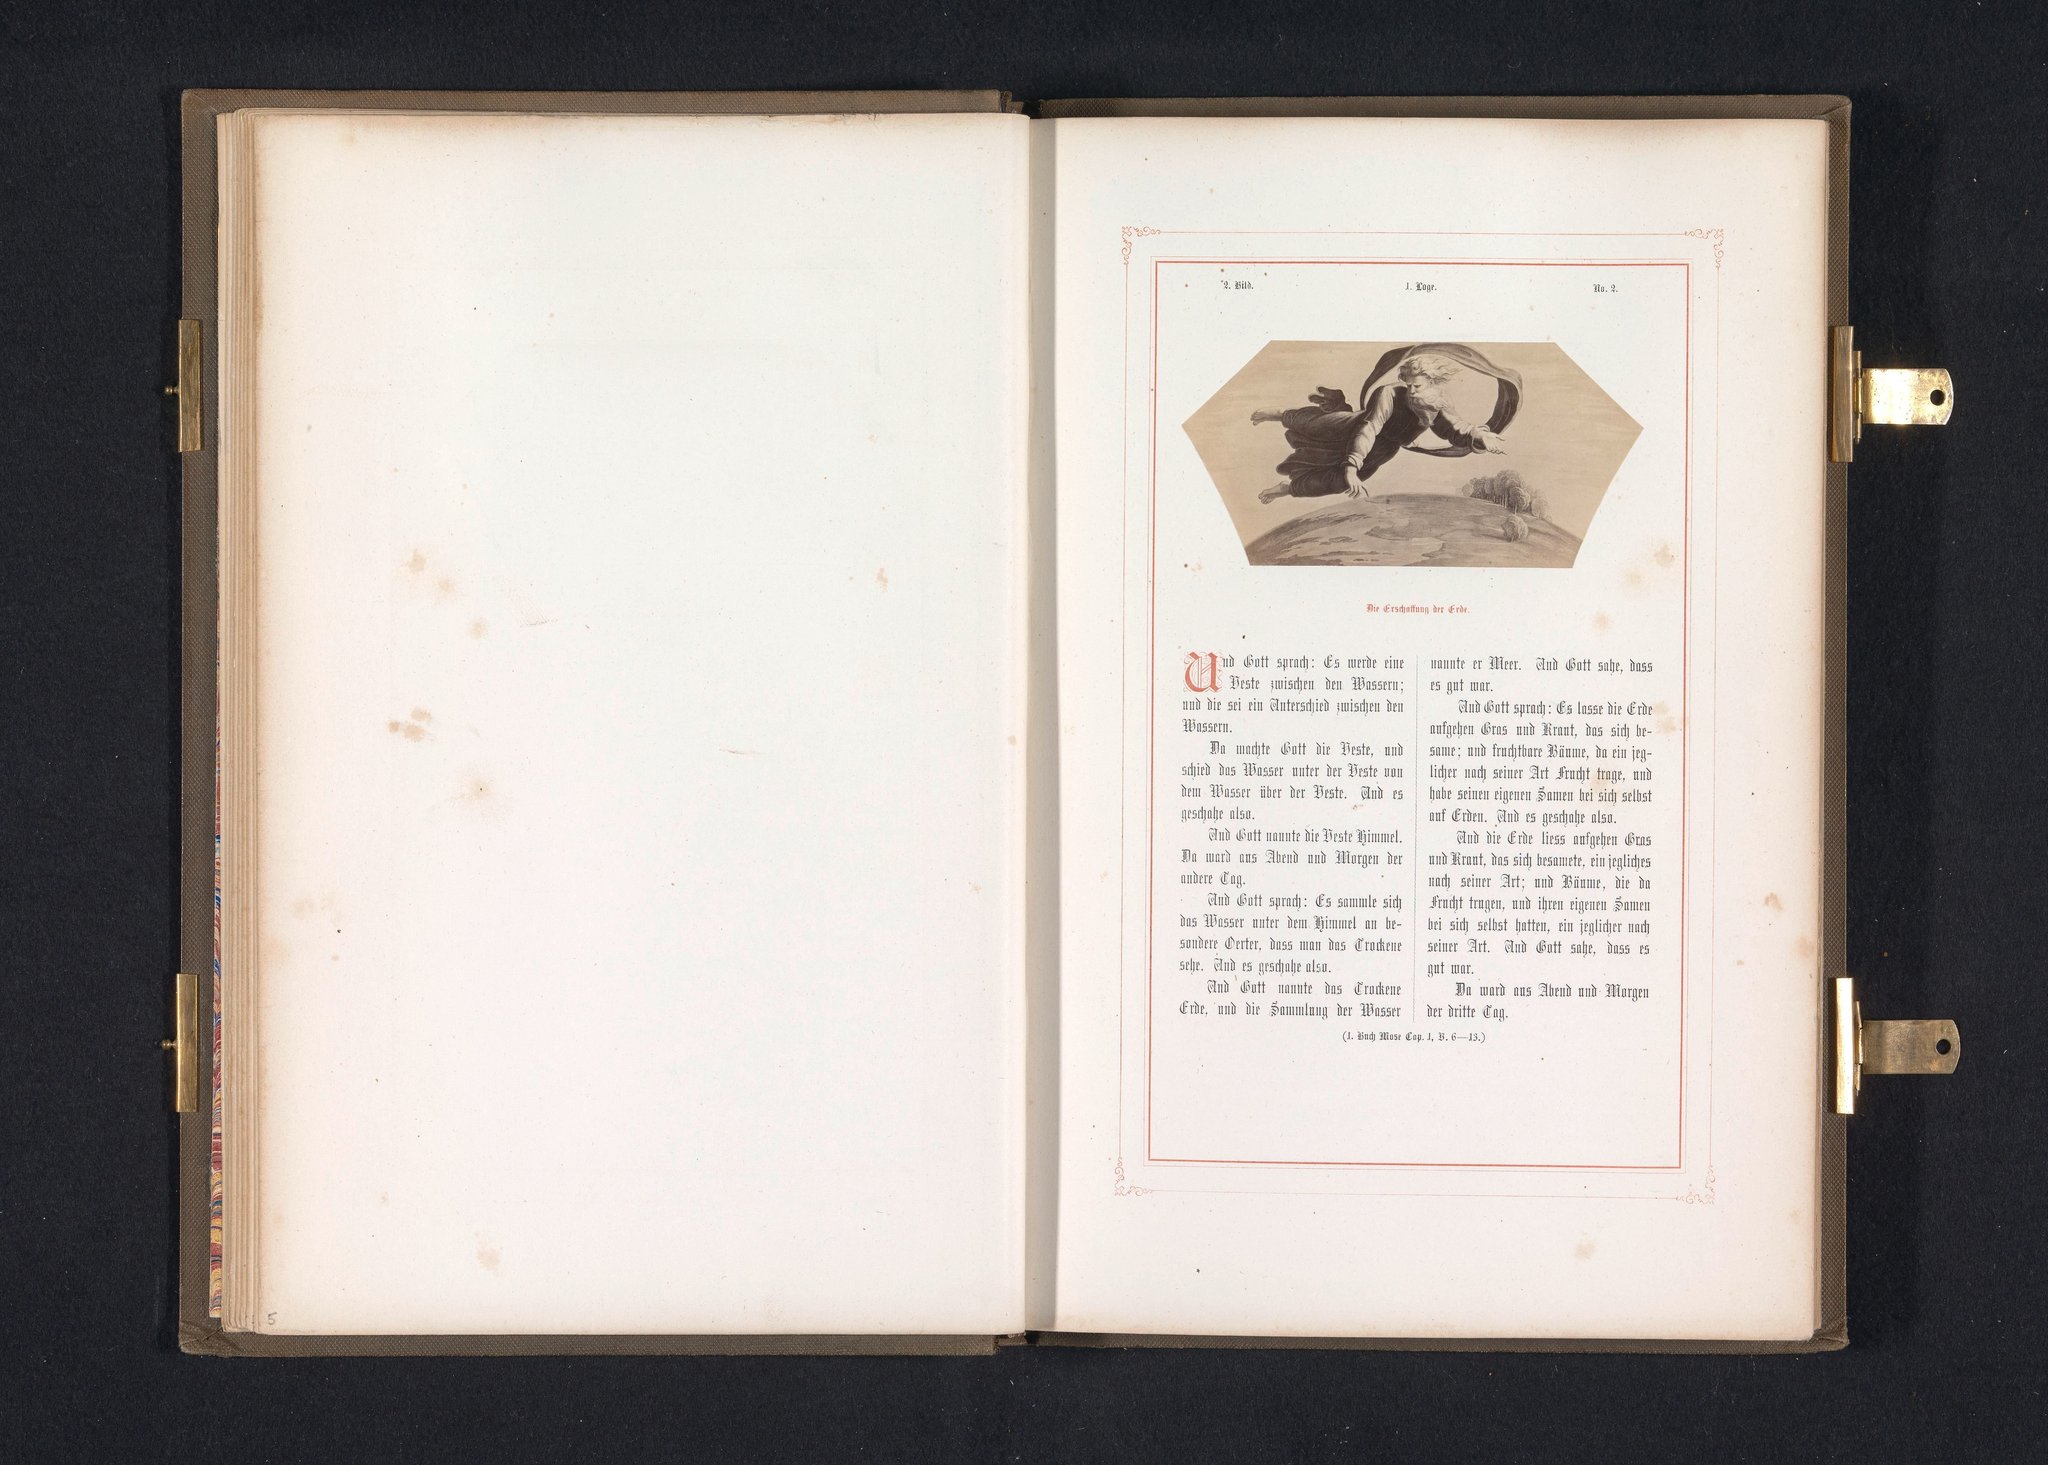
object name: page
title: Fotoreproductie van een prent naar een fresco van de schepping van de aarde door Rafaël voor de loggia's in het Vaticaan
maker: gustav schauer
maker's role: painter, publisher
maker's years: 1826-1902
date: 1851-1861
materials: photographic support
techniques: albumen print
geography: berlin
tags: the six days of creation (genesis 1:3-25)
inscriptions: inscription: ‘2. Bild. 1. Loge. No.2.’